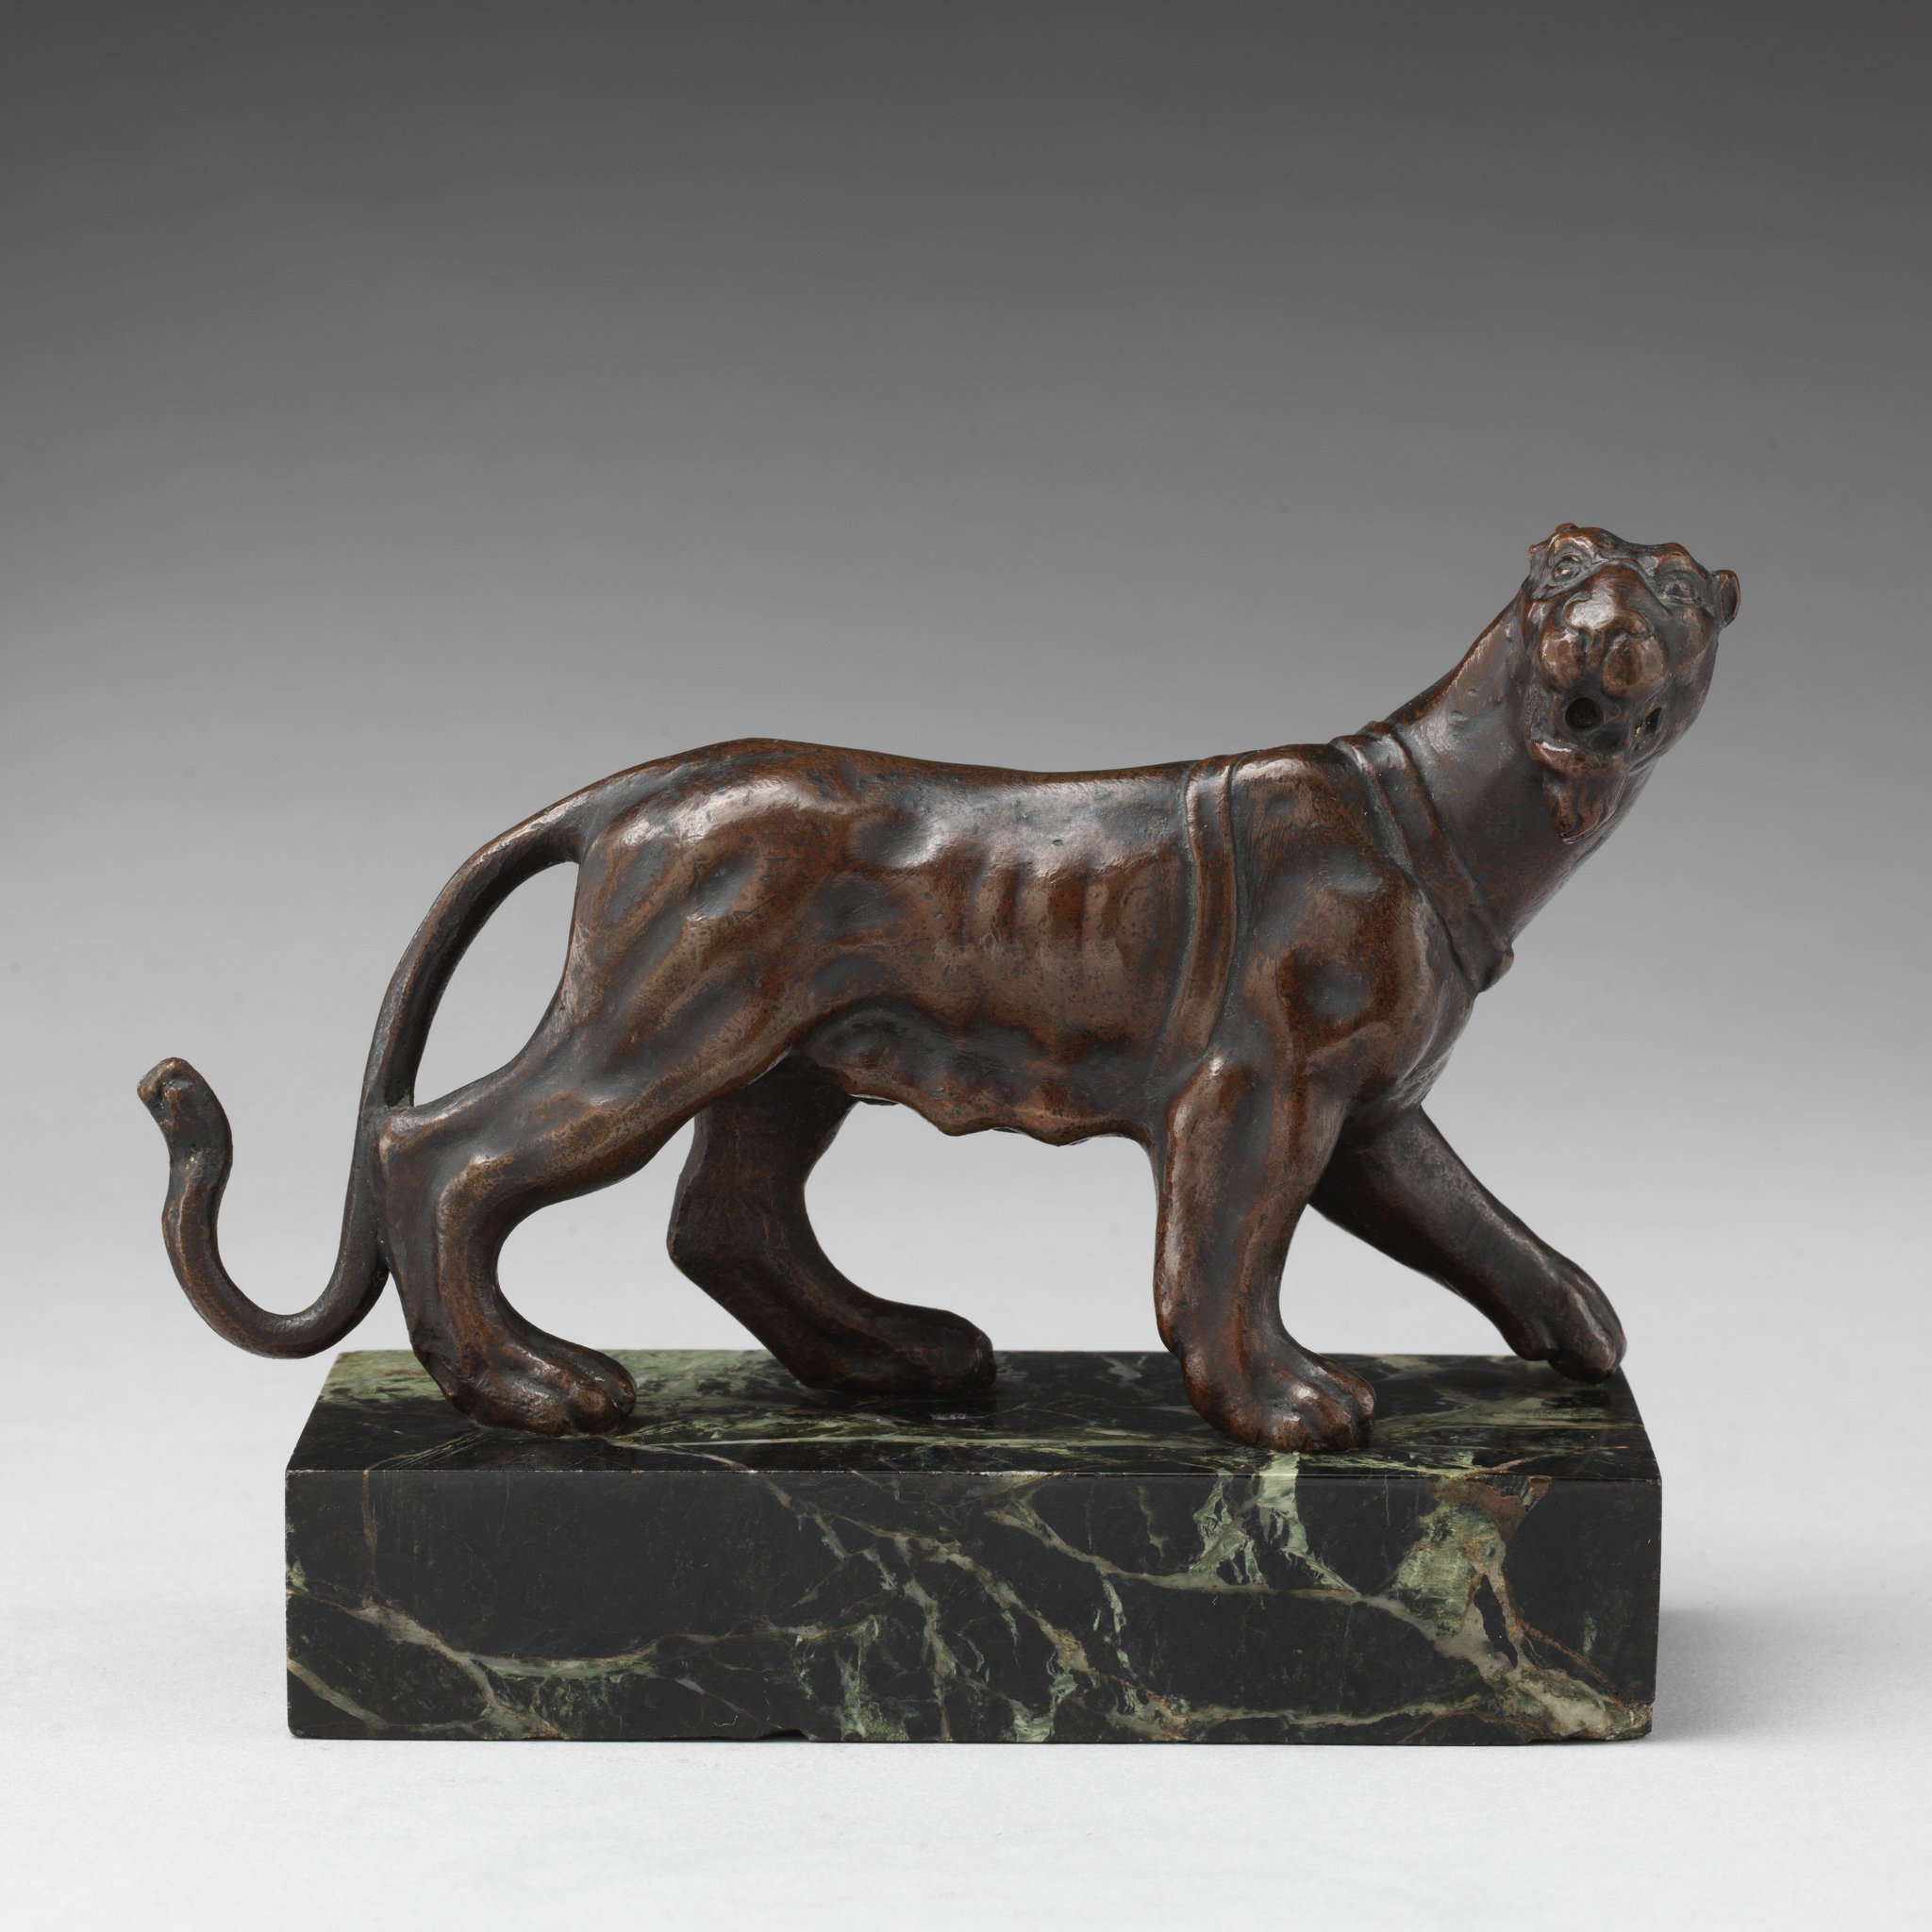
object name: statuette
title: Lioness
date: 1501-1600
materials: bronze, lacquer, patina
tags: animals